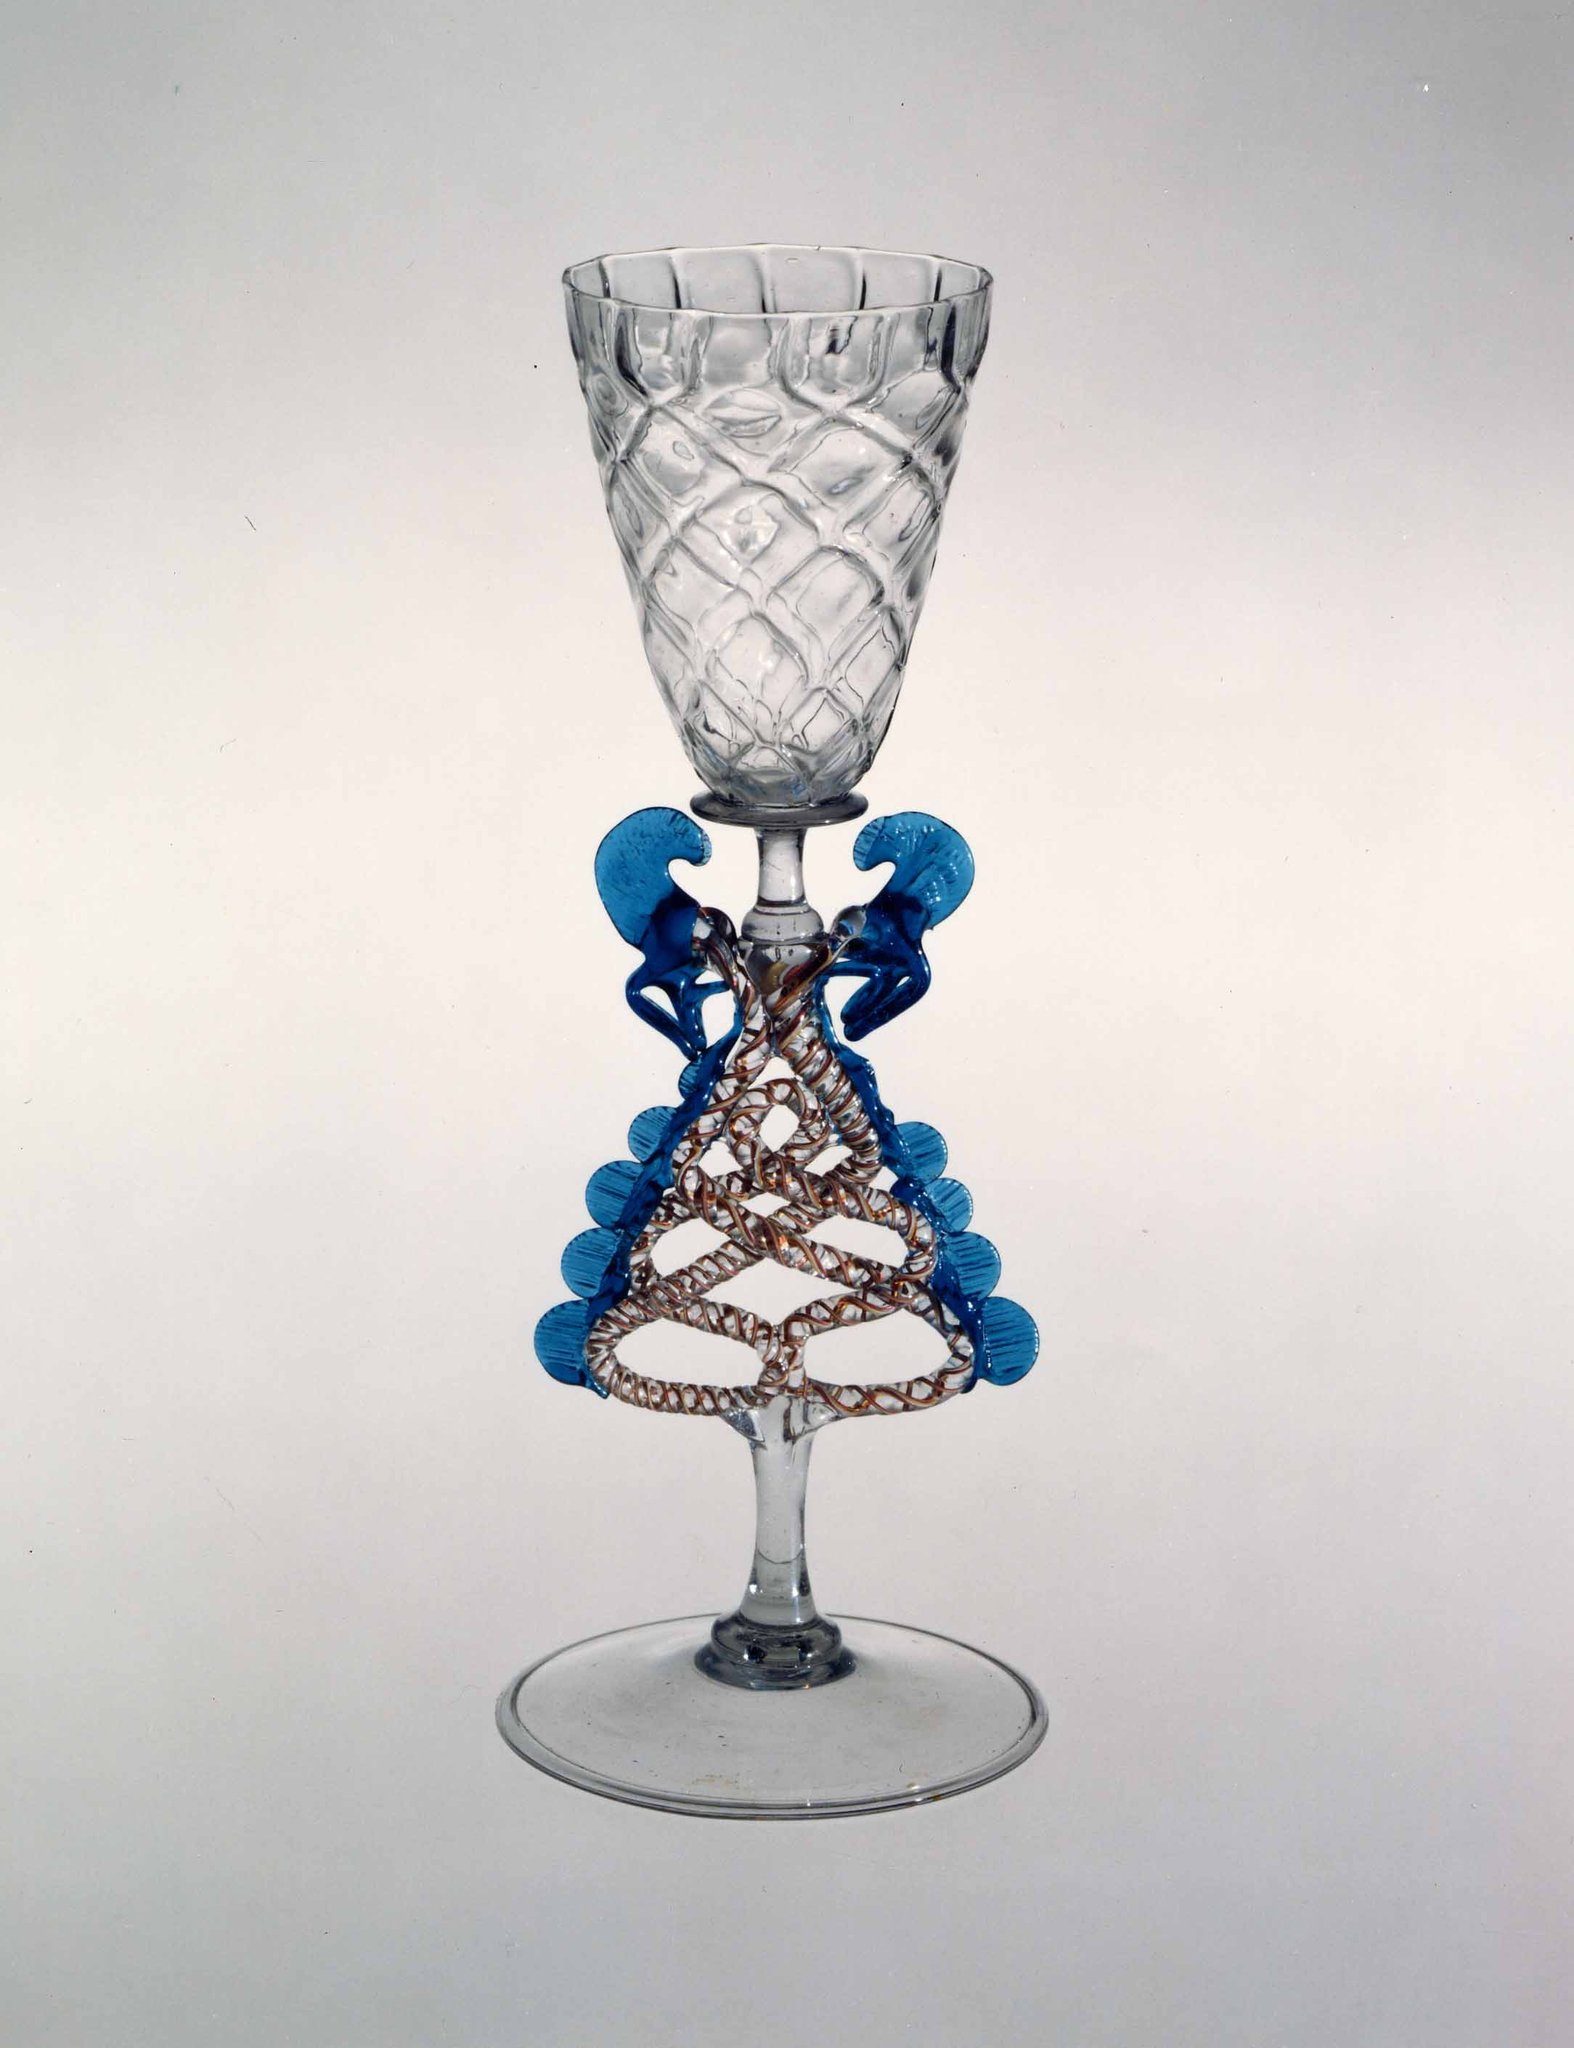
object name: goblet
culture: façon de venise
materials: brick, glass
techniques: glassblowing, molding